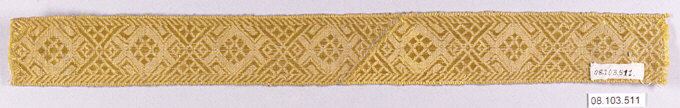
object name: galloon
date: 1701-1800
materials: cotton, silk